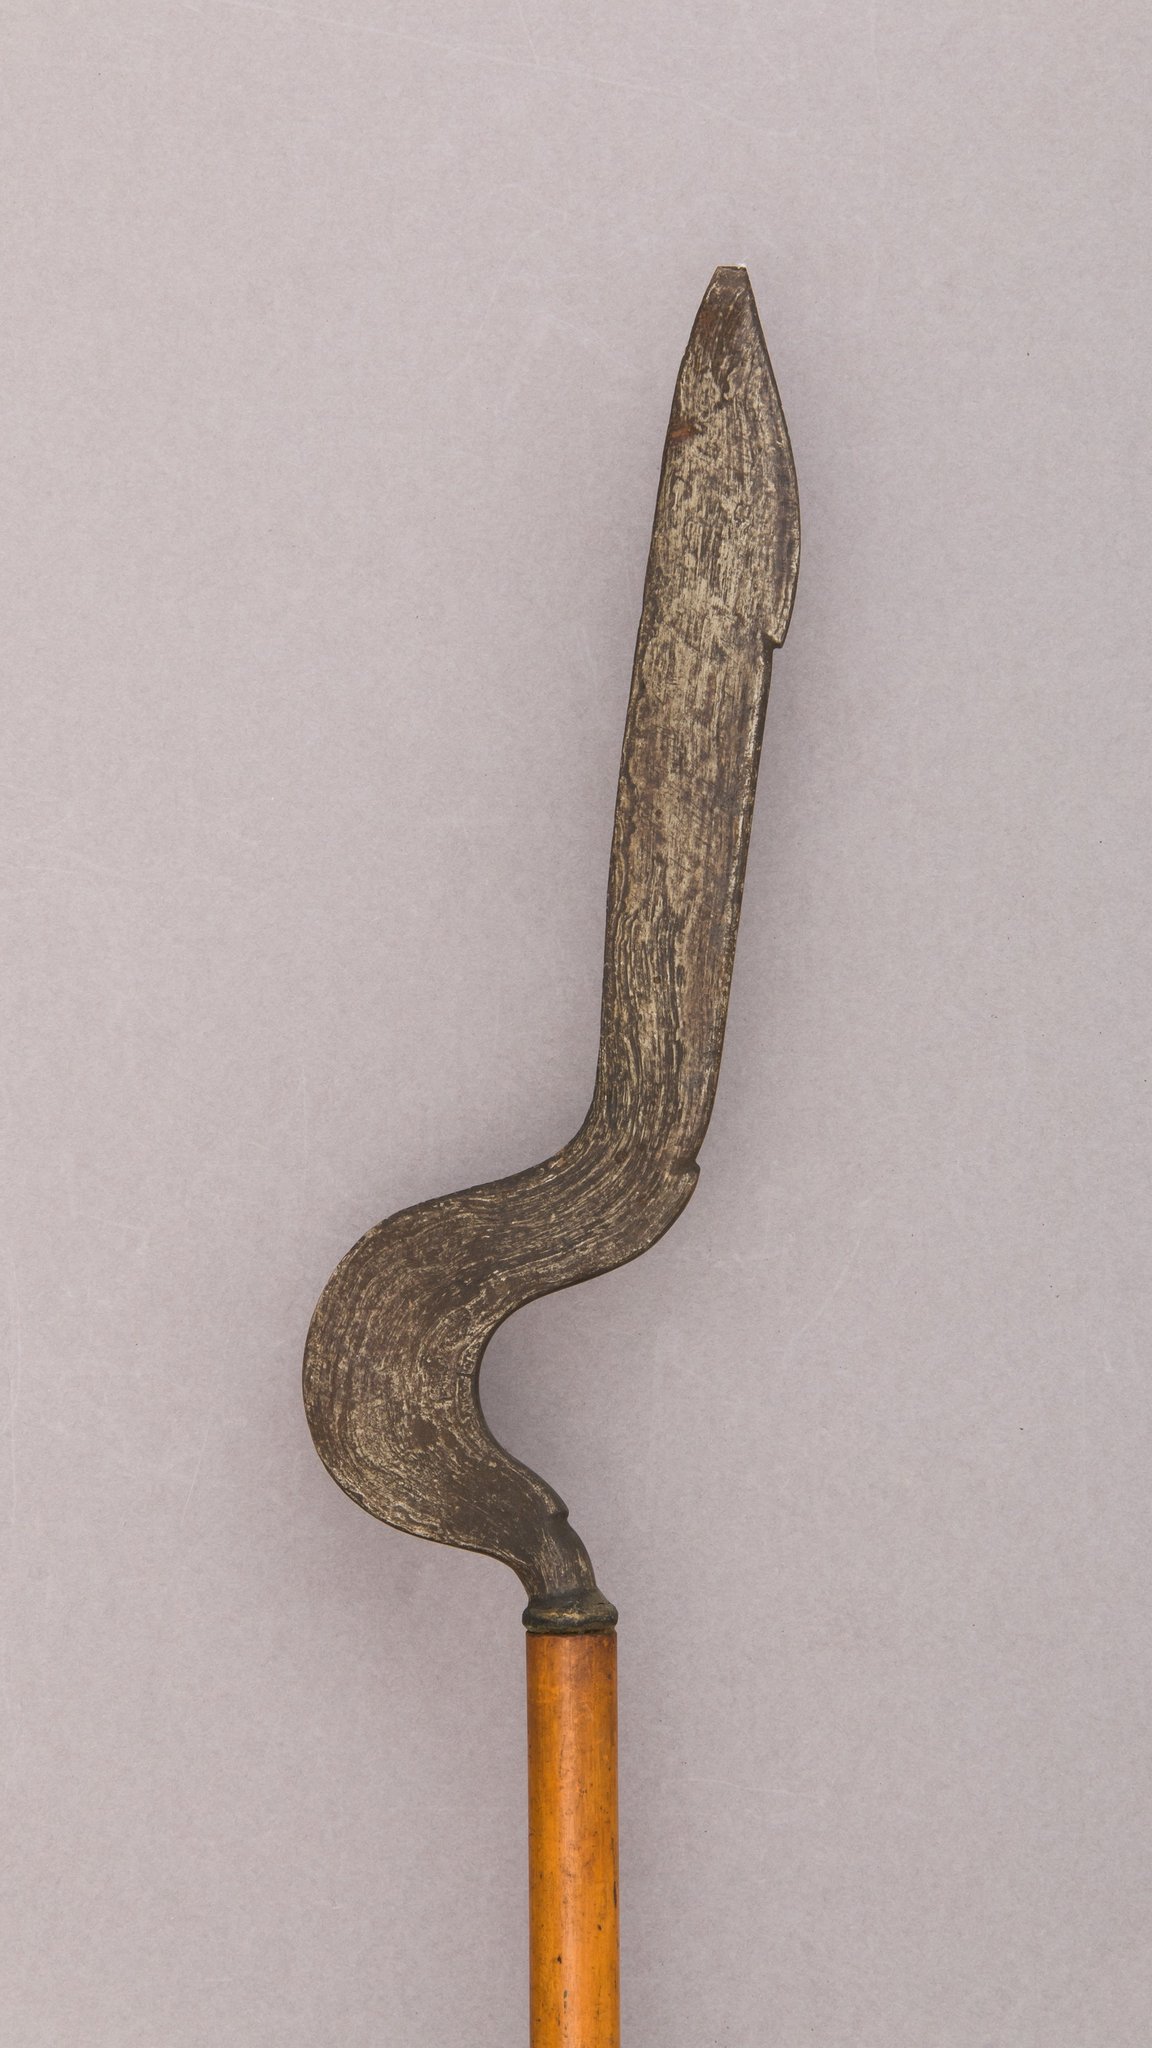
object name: spear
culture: javanese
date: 1501-1900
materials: bamboo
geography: indonesia